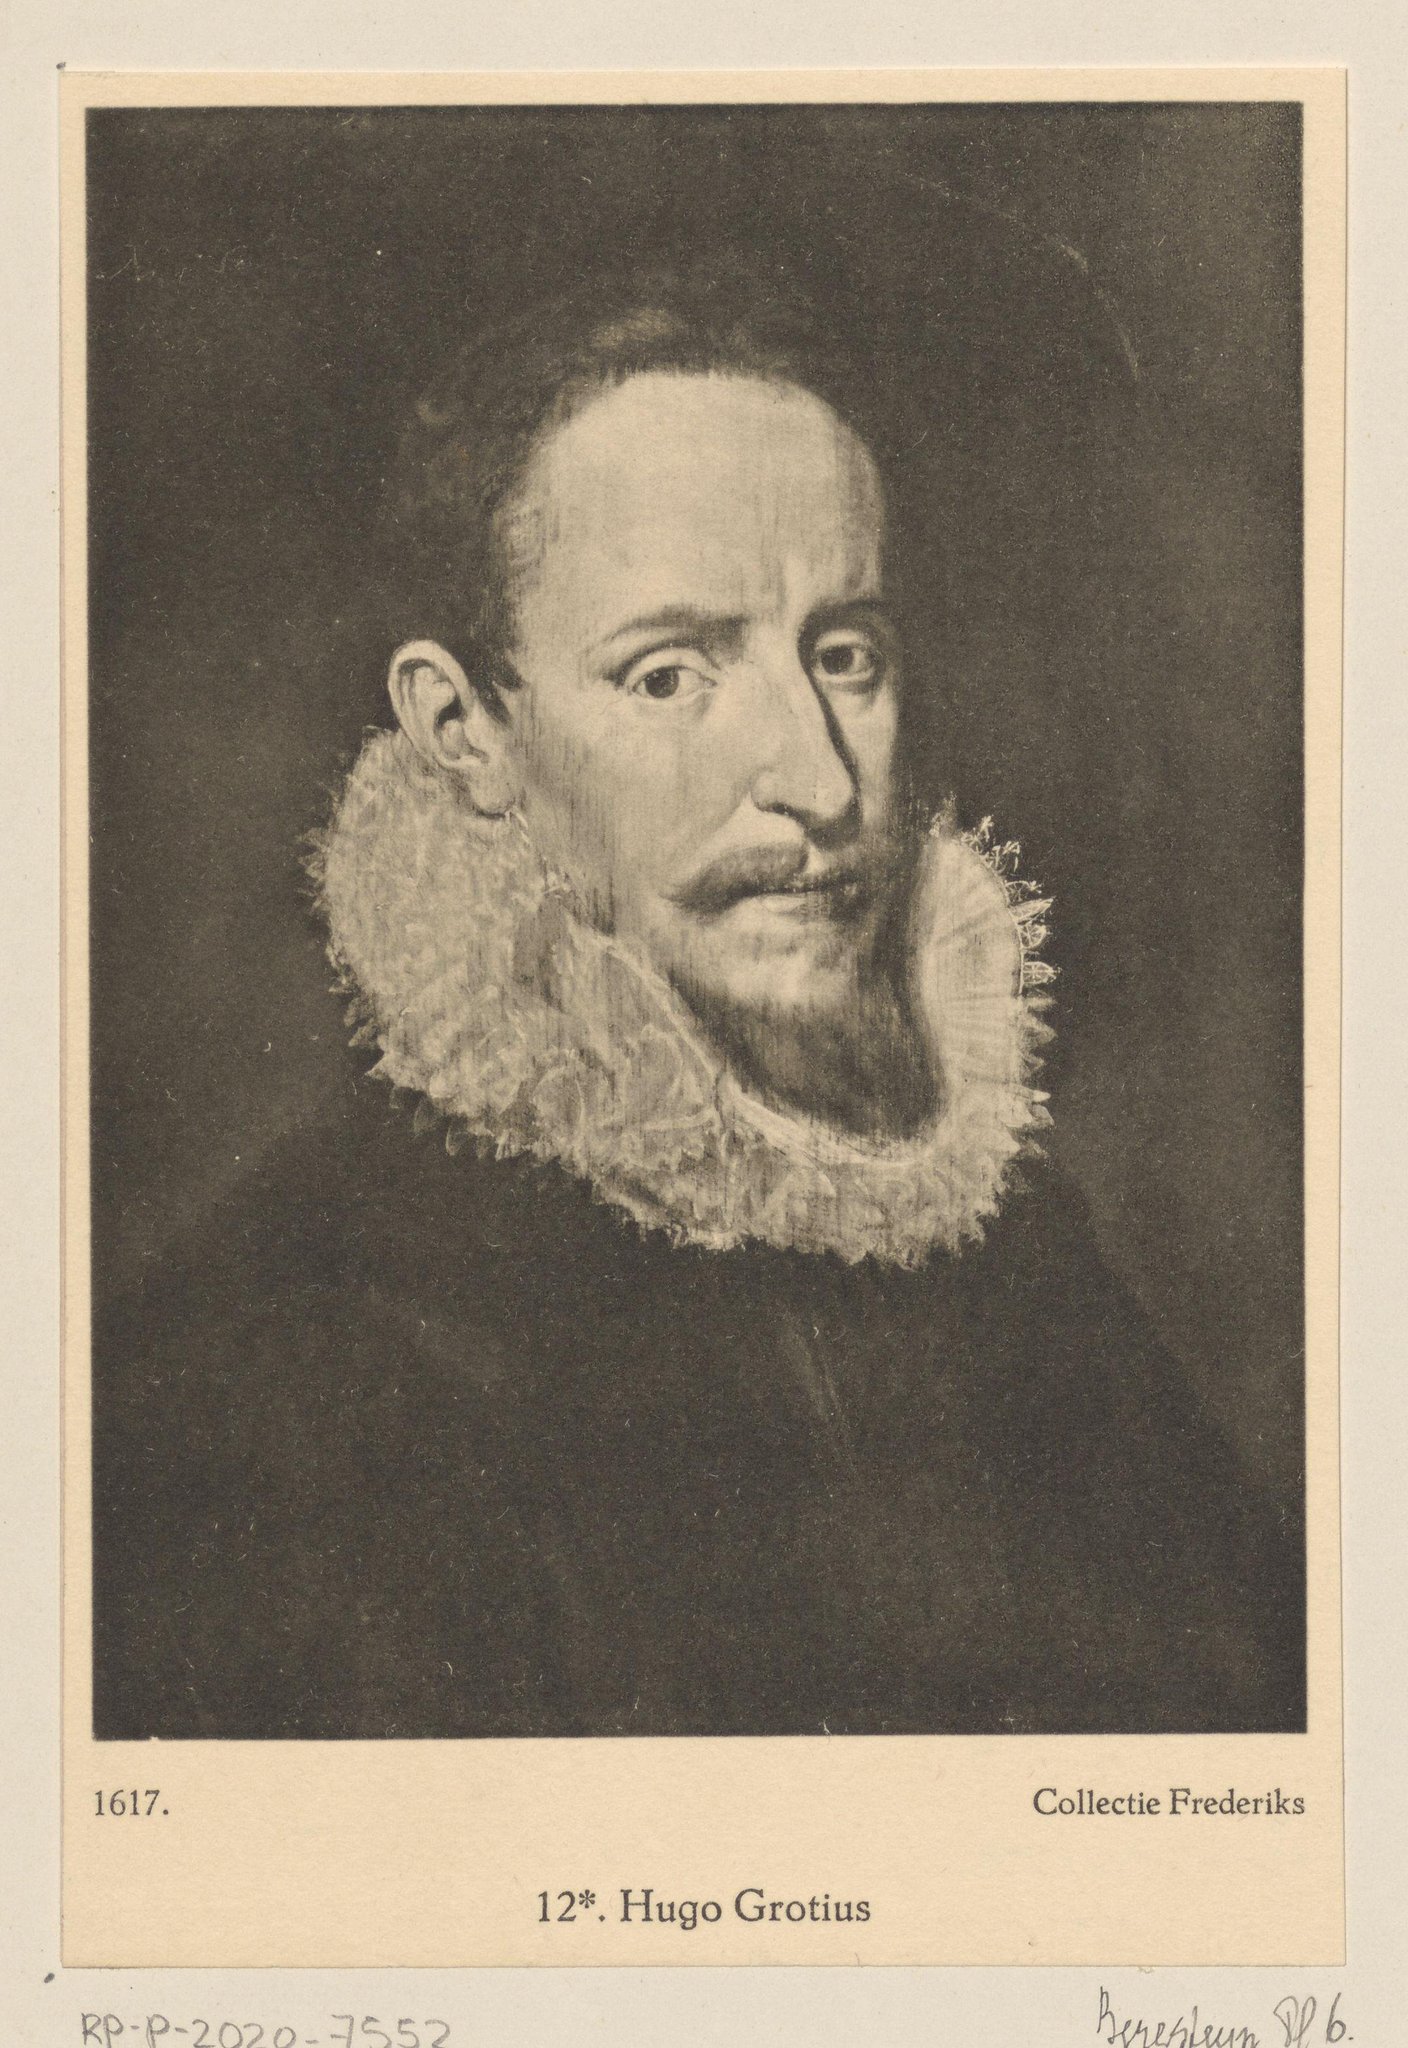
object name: photomechanical print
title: Portret van Hugo de Groot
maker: Anonymous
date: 1880-1920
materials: paper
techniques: photograph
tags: delft, hugo de groot, historical persons, portrait of a writer